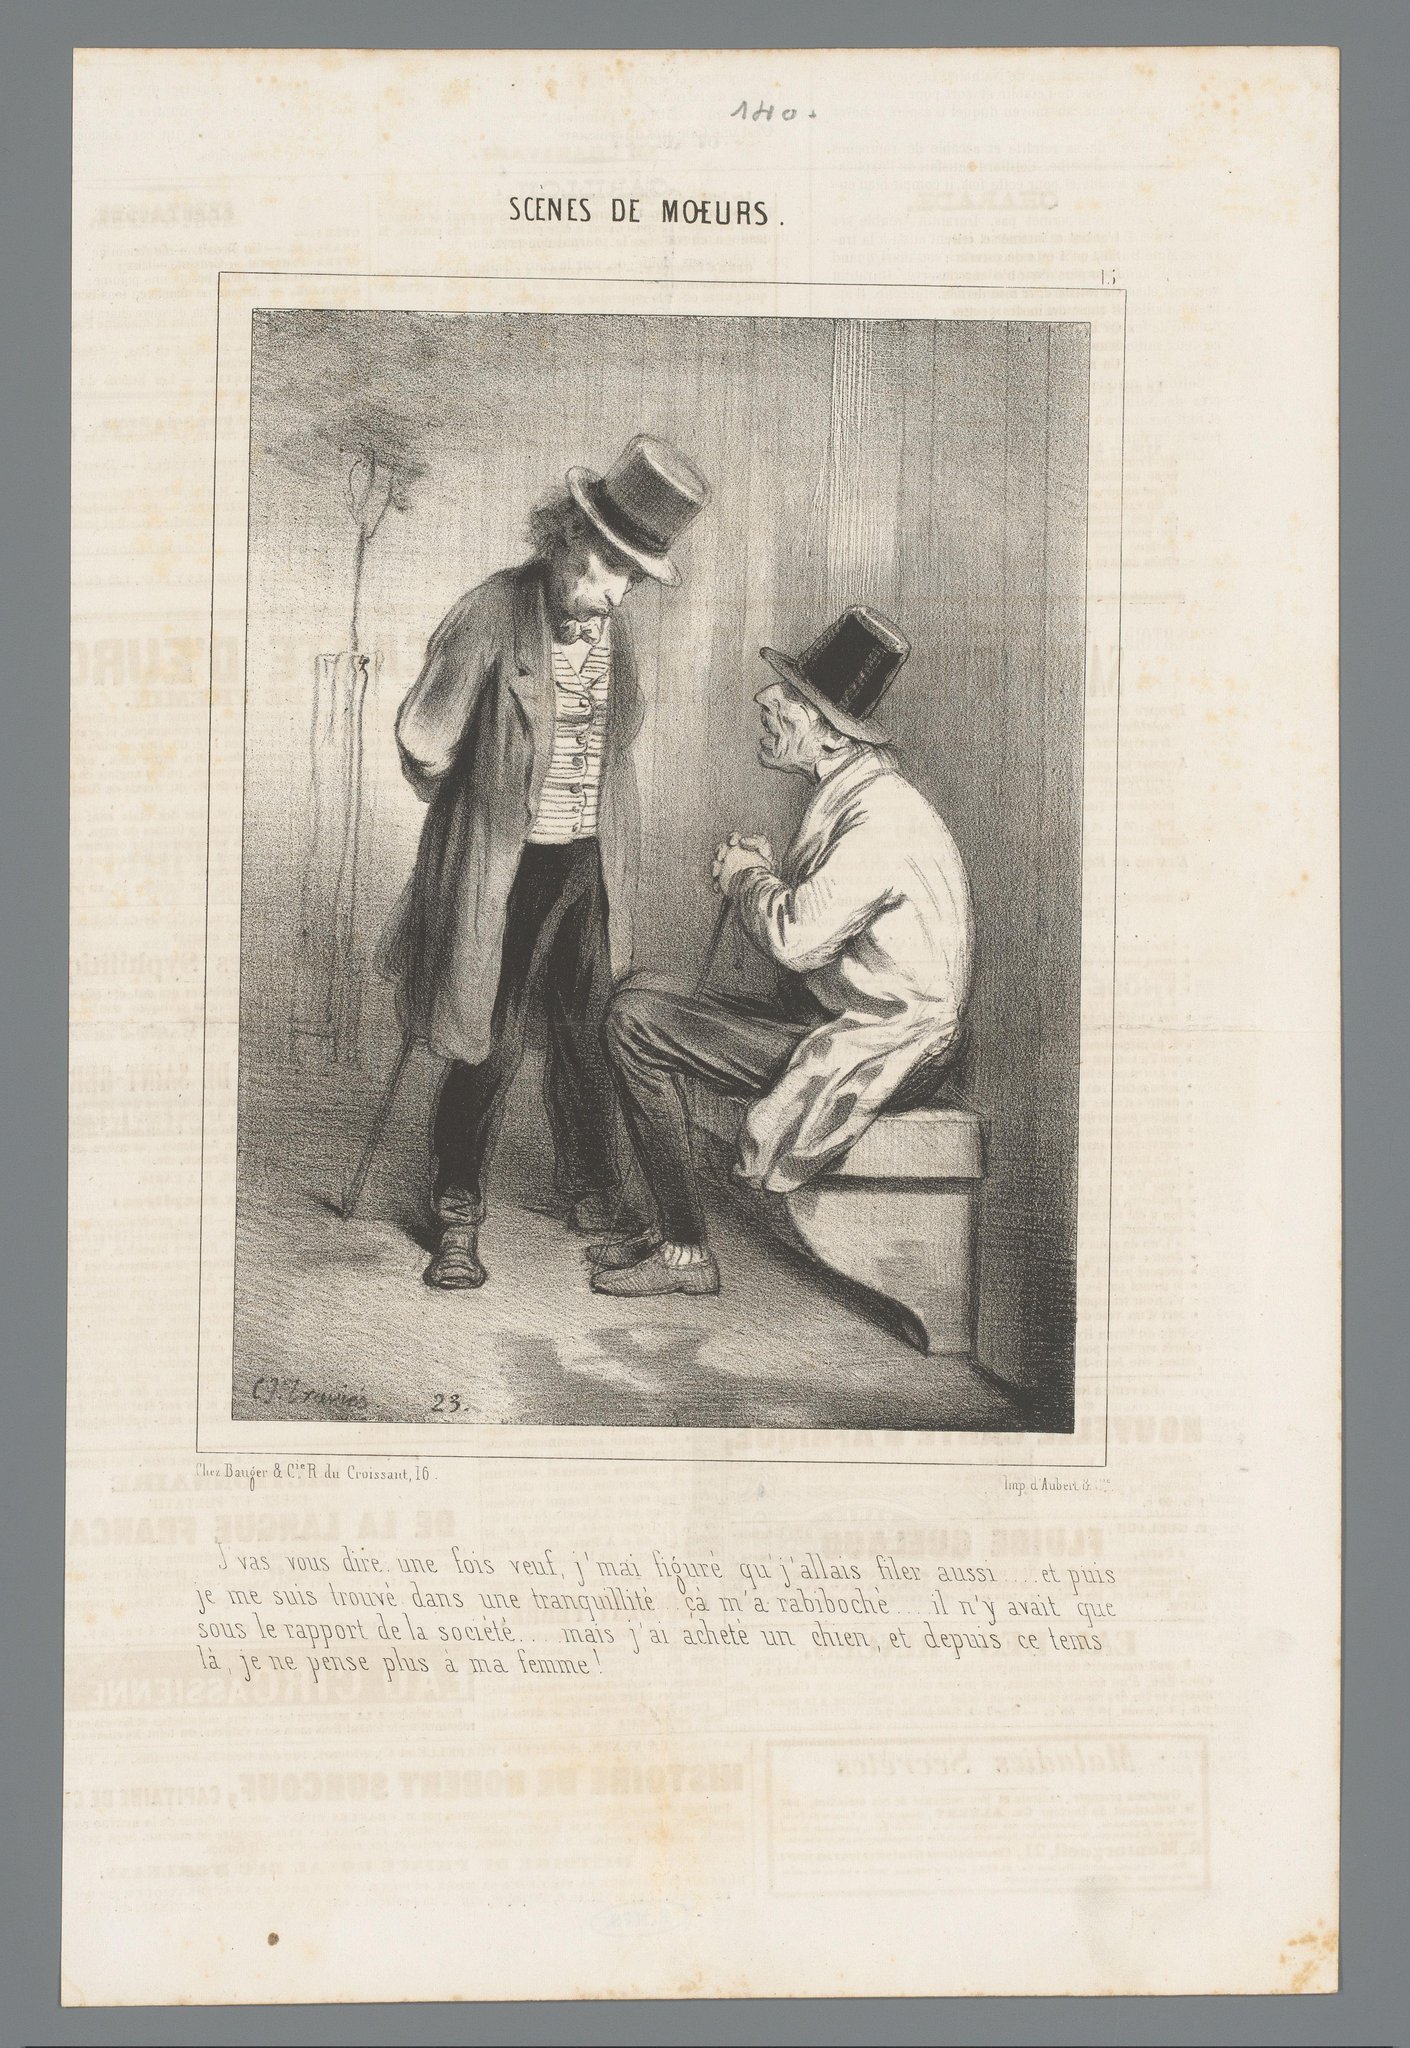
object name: cartoon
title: Twee oude mannen in gesprek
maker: charles-joseph traviès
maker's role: print maker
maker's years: 1804-1859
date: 1841-1842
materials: paper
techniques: letterpress printing, lithograph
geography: paris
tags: old man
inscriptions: collector's mark: Lugt 2228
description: Prent uit: Le Charivari van 1841 of 1842.